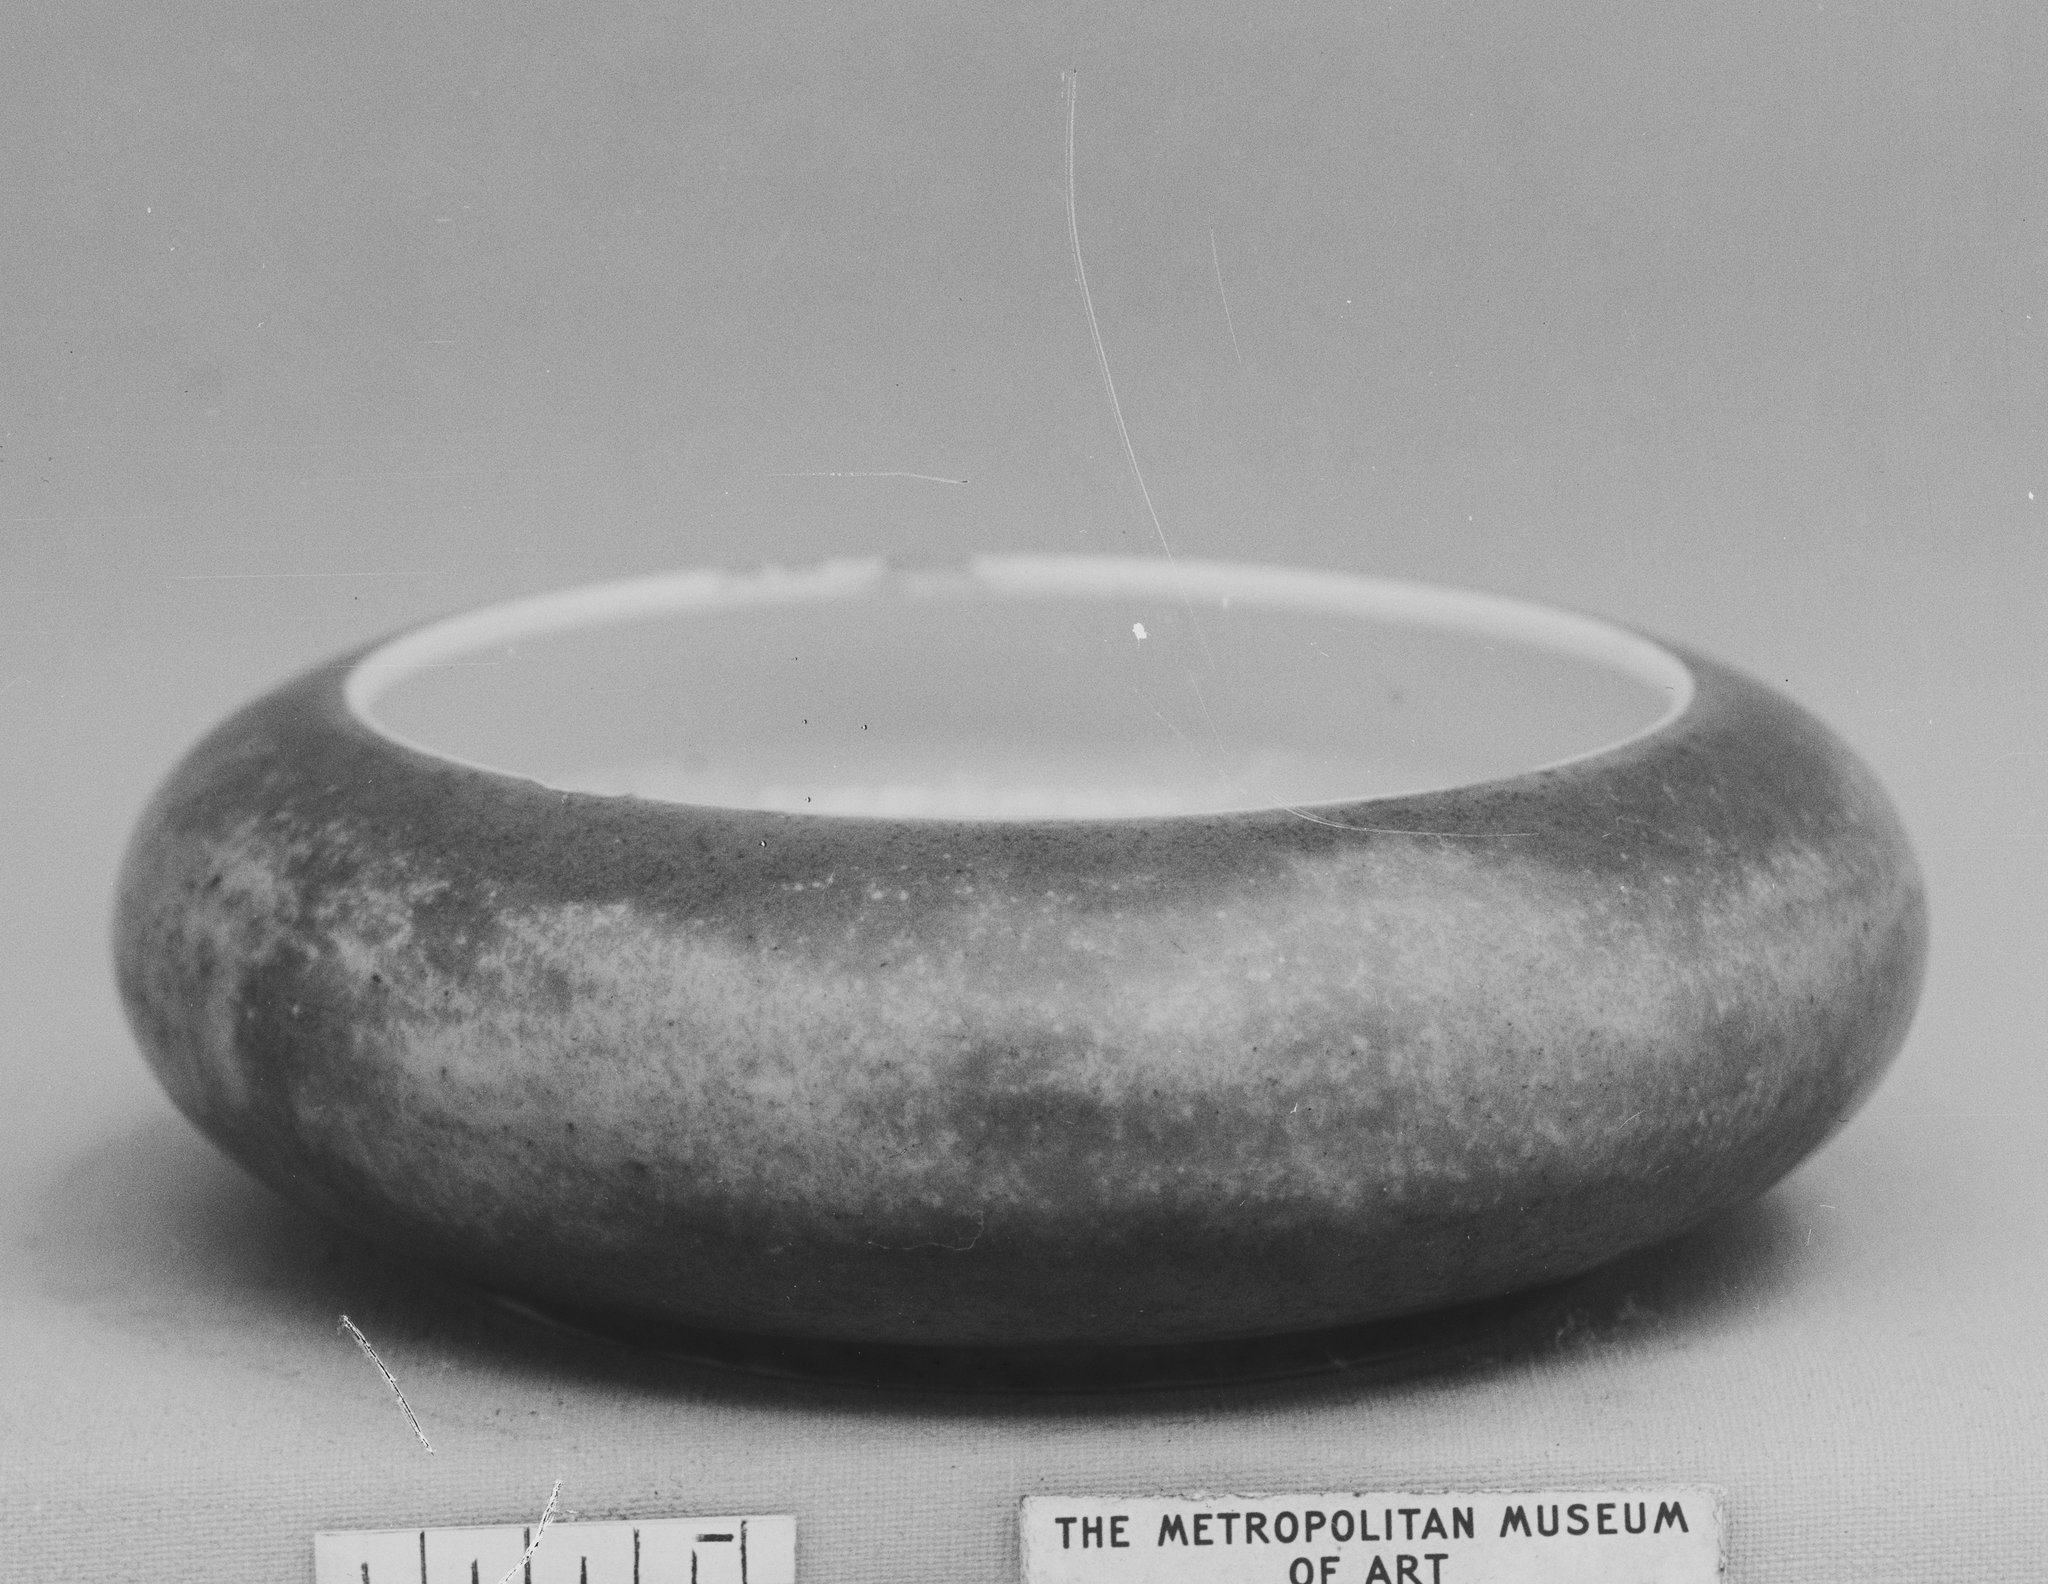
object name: bowl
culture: chinese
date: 1662-1722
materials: porcelain